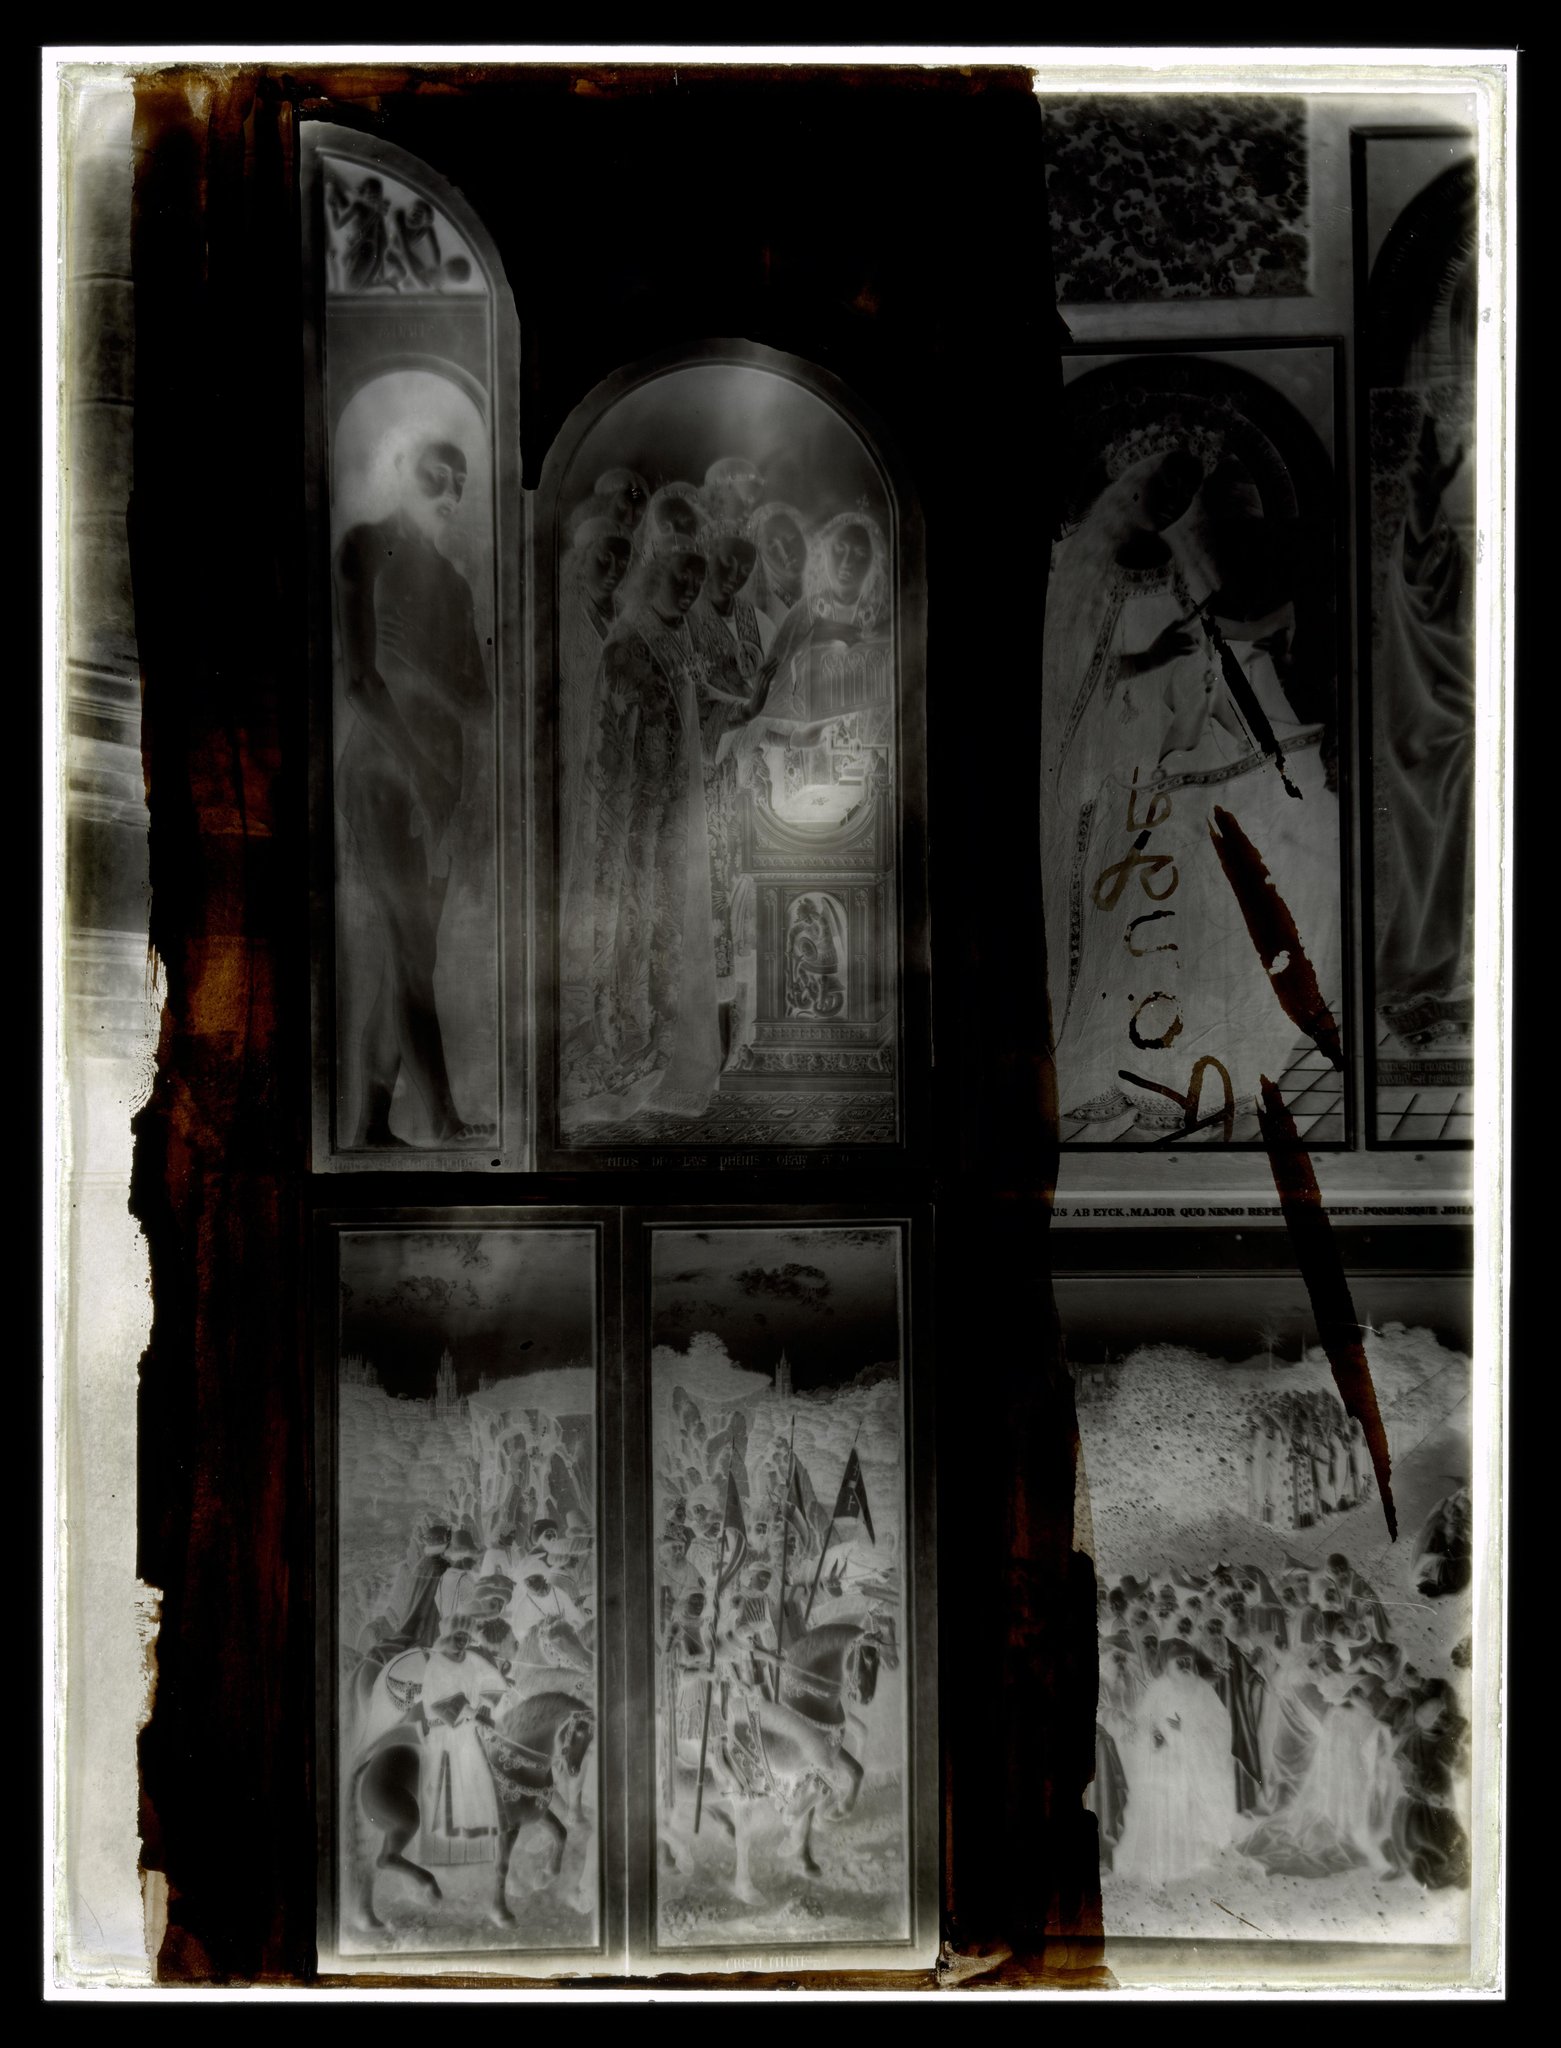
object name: negative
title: Deelnegatief van het linkerpaneel van het altaarstuk De aanbidding van het Lam Gods door Hubert en Jan van Eyck, opgesteld in de Sint-Baafskathedraal, Gent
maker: Anonymous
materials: glass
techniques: gelatin silver negative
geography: ghent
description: Gefotografeerd door een rood-, groen- en blauwfilter.